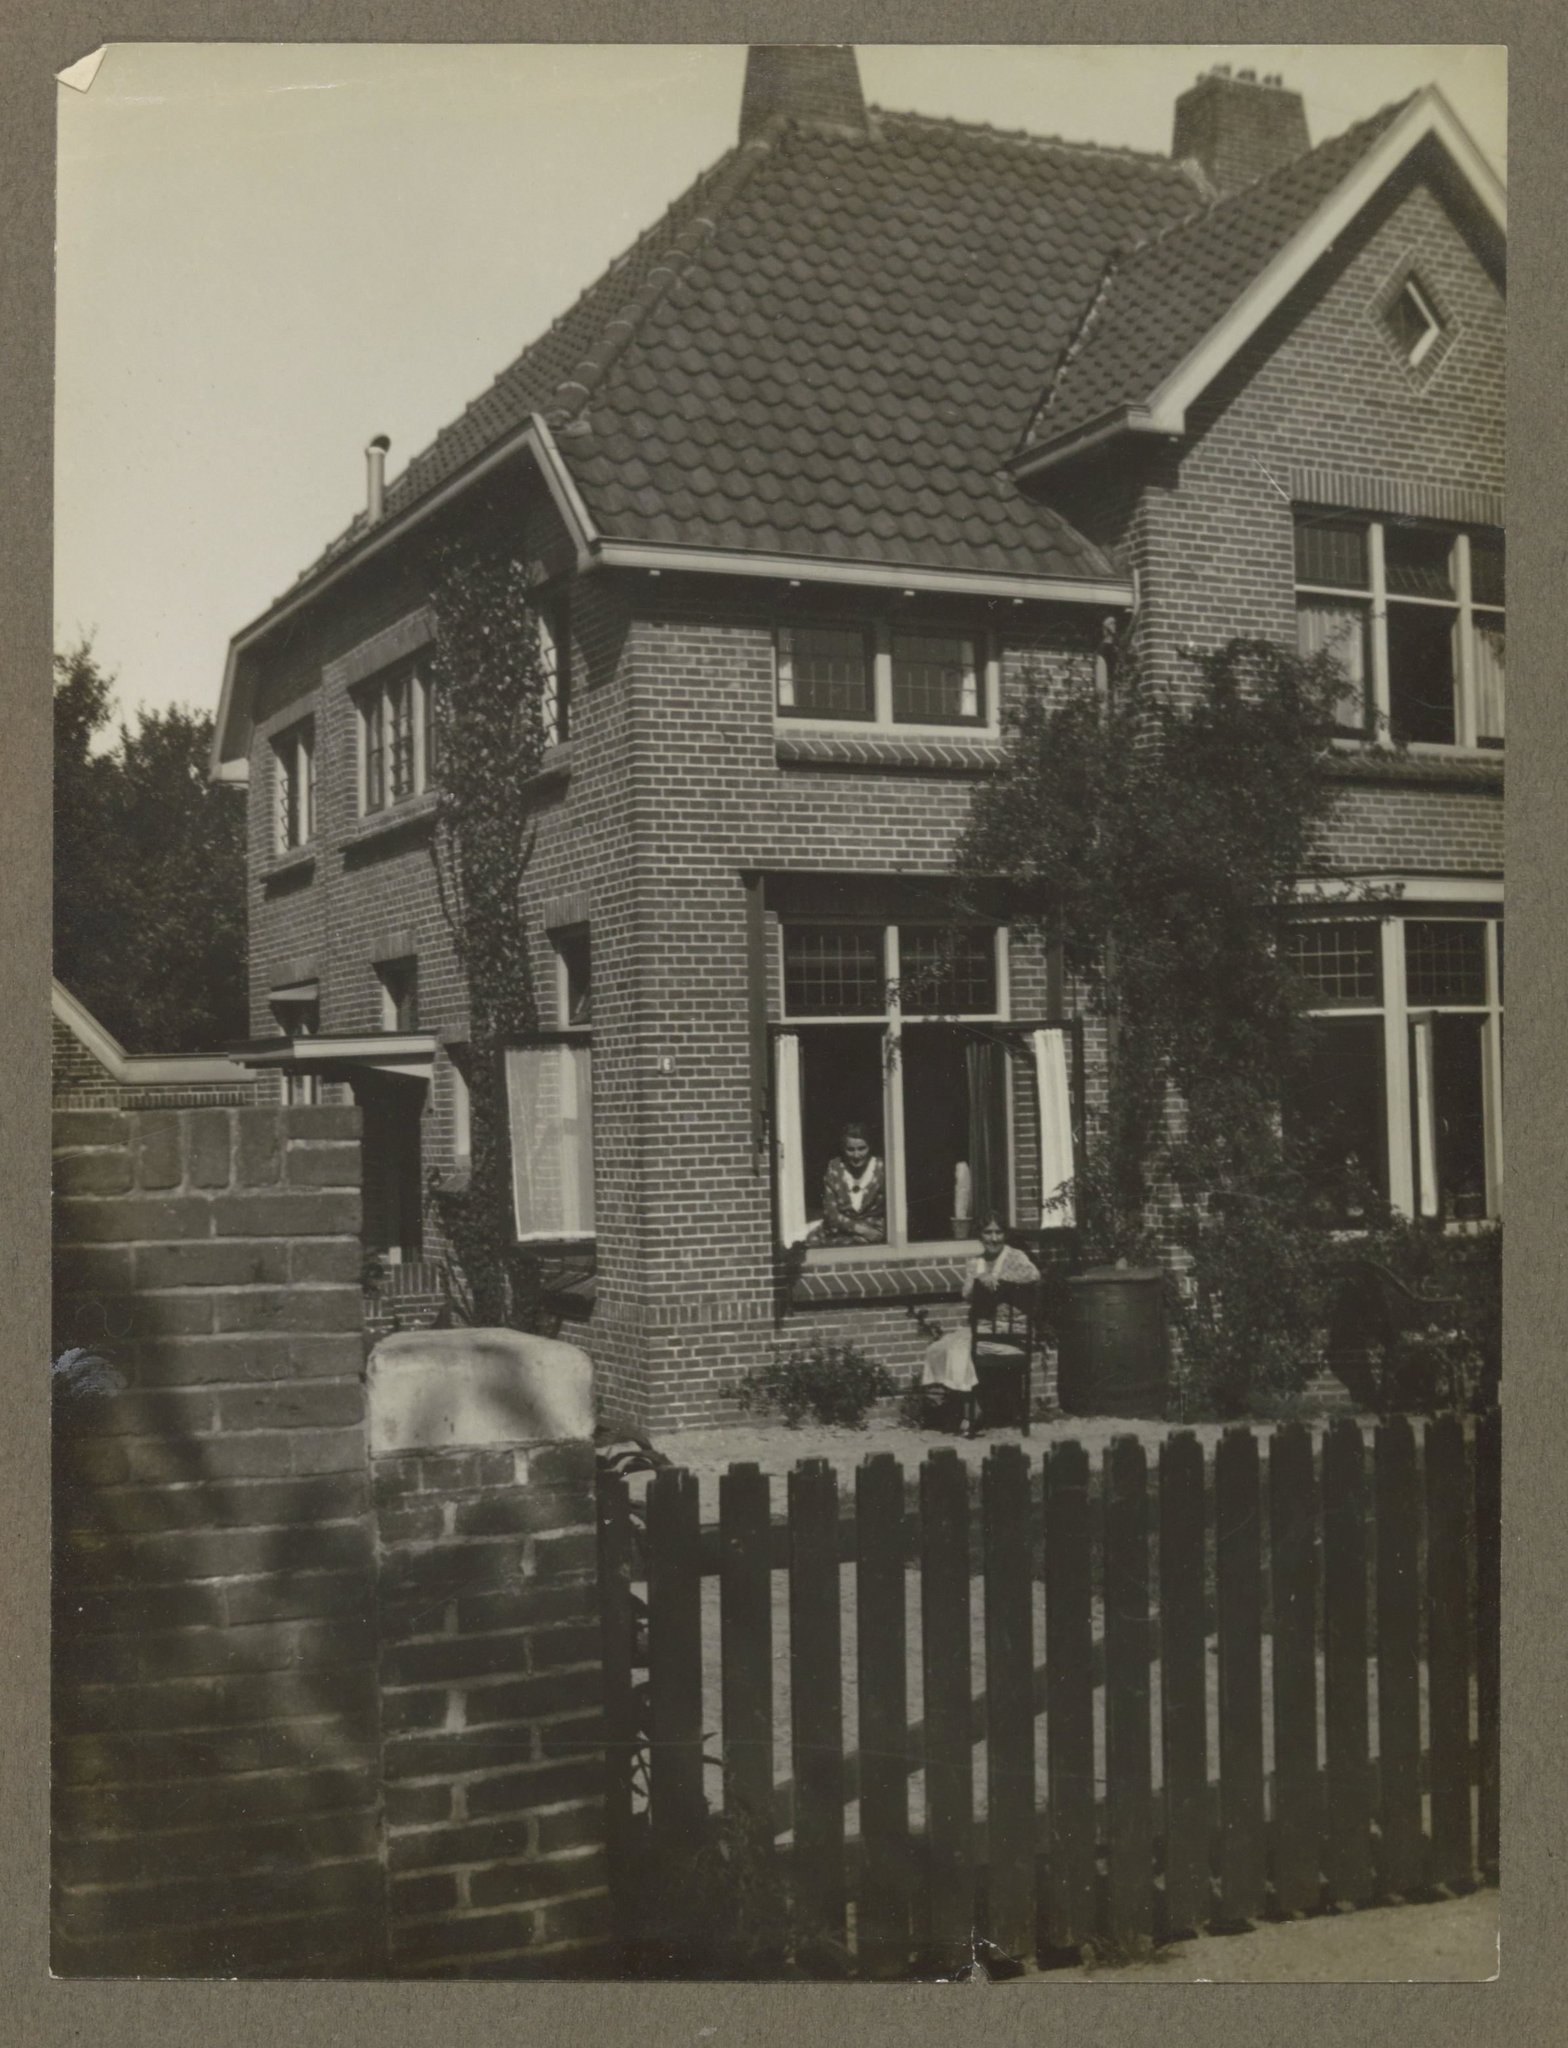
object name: photograph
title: Twee vrouwen bij een woonhuis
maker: Anonymous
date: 1920-1930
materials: photographic support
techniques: gelatin silver print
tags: façade (of house or building)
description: Onderdeel van fotoalbum van een onbekende Nederlandse familie met opnames van Suriname, Europa en Nederlands-Indië.